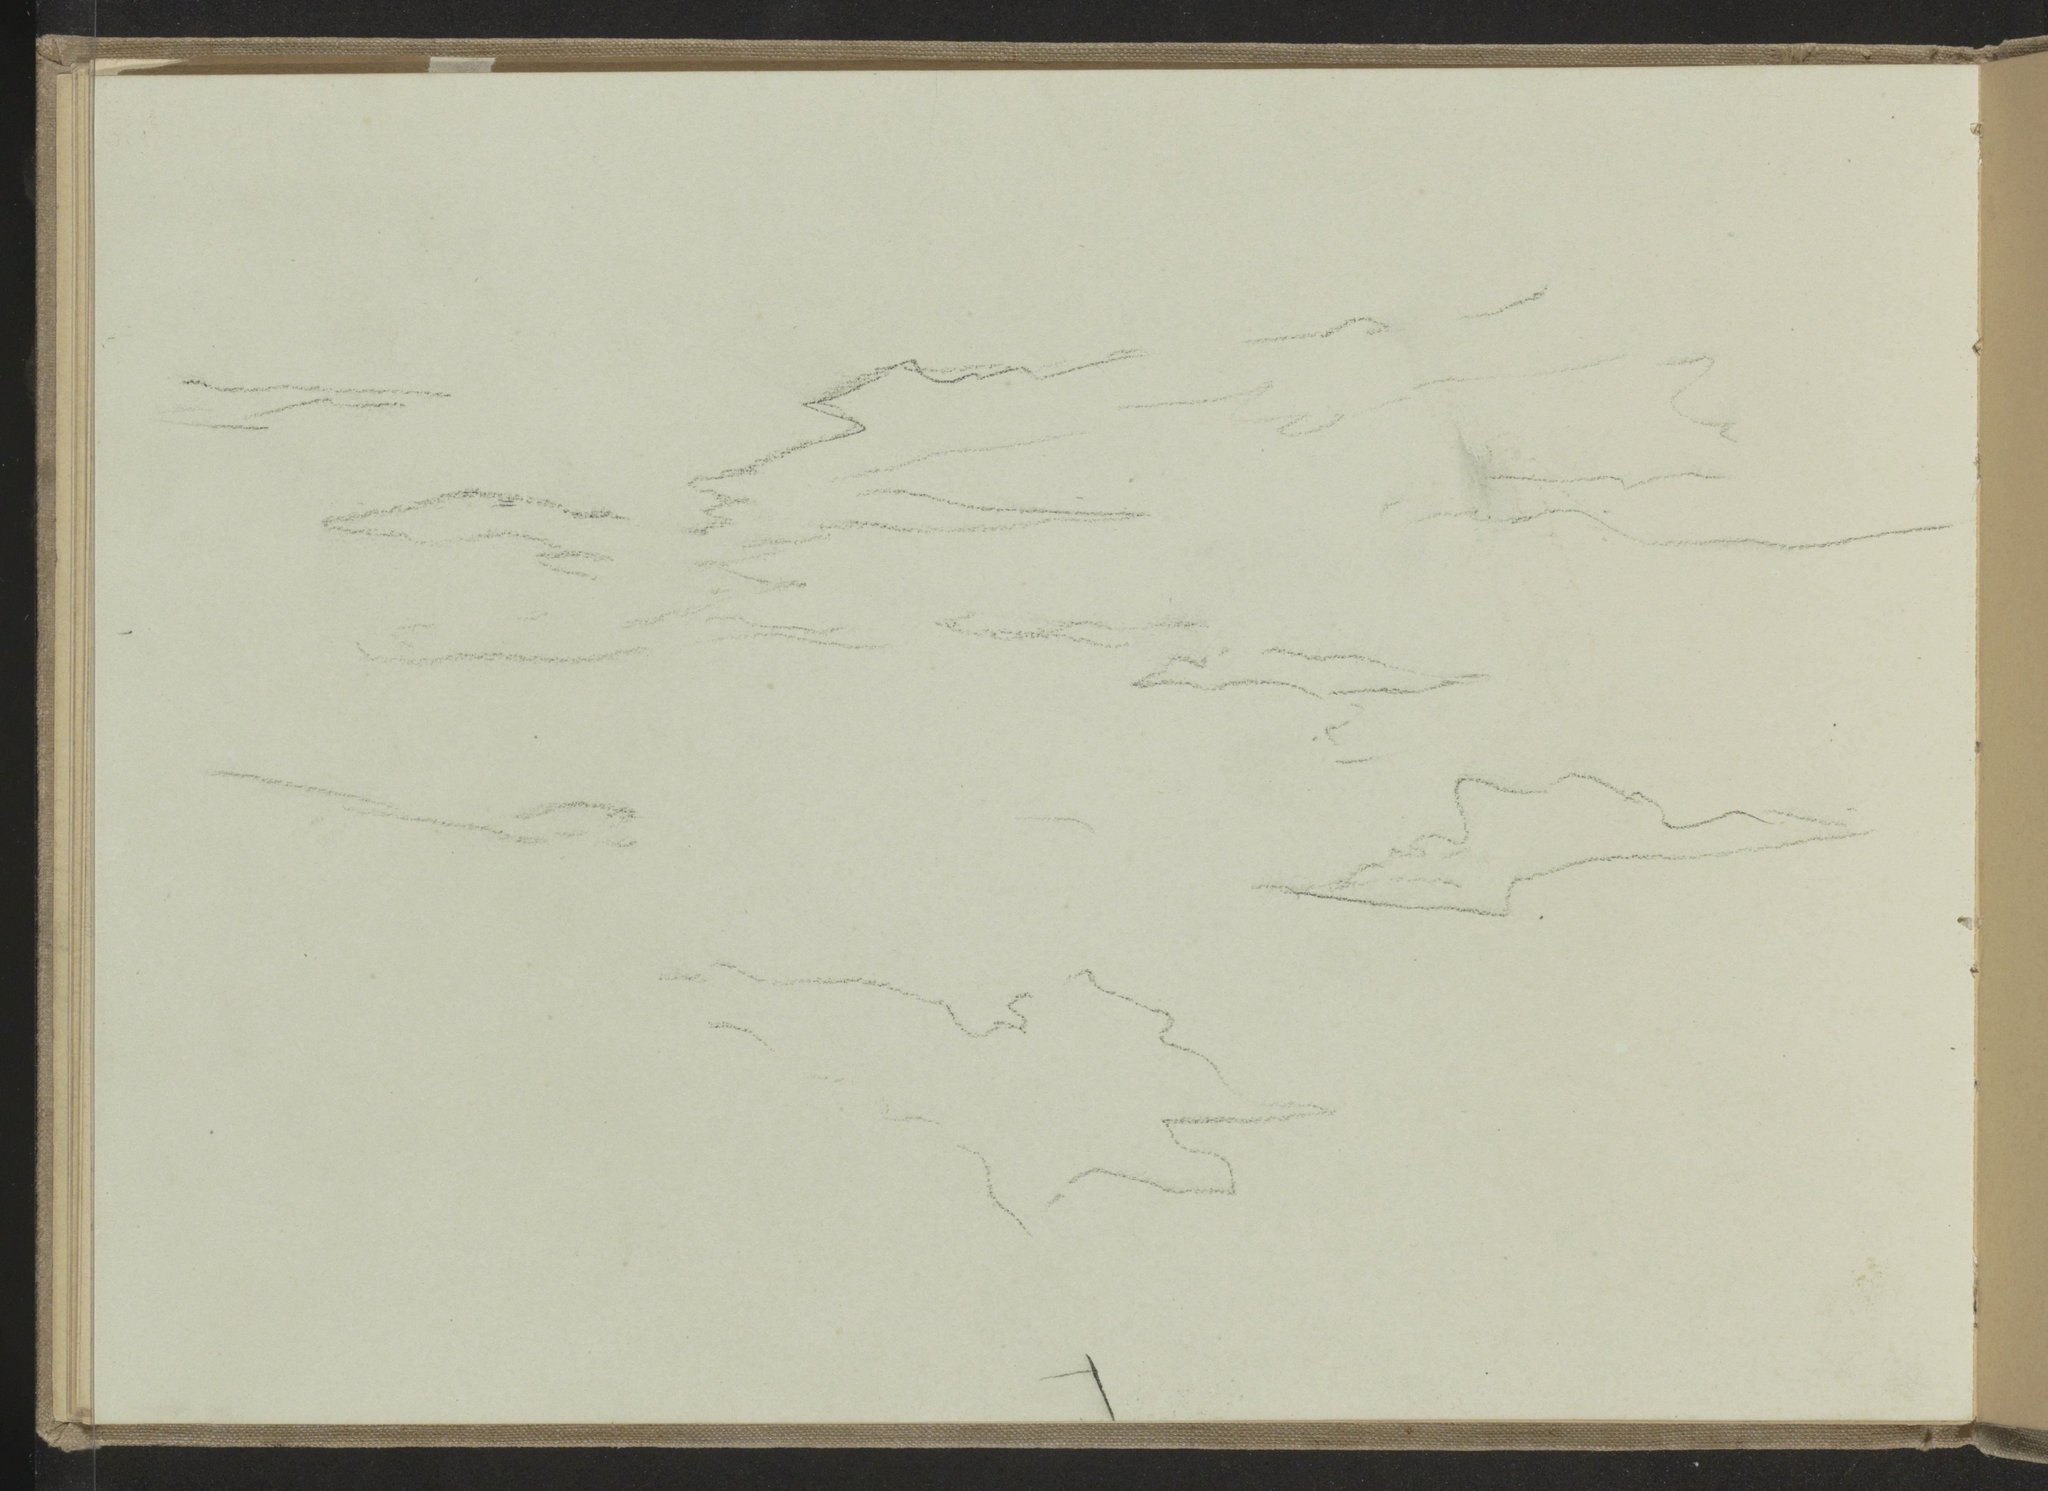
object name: sketchbook leaf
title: Wolken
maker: jozef israëls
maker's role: draughtsman, painter, print maker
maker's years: 1824-1911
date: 1834-1911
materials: chalk, paper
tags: clouds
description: Blad 24 verso uit een schetsboek met 27 bladen.